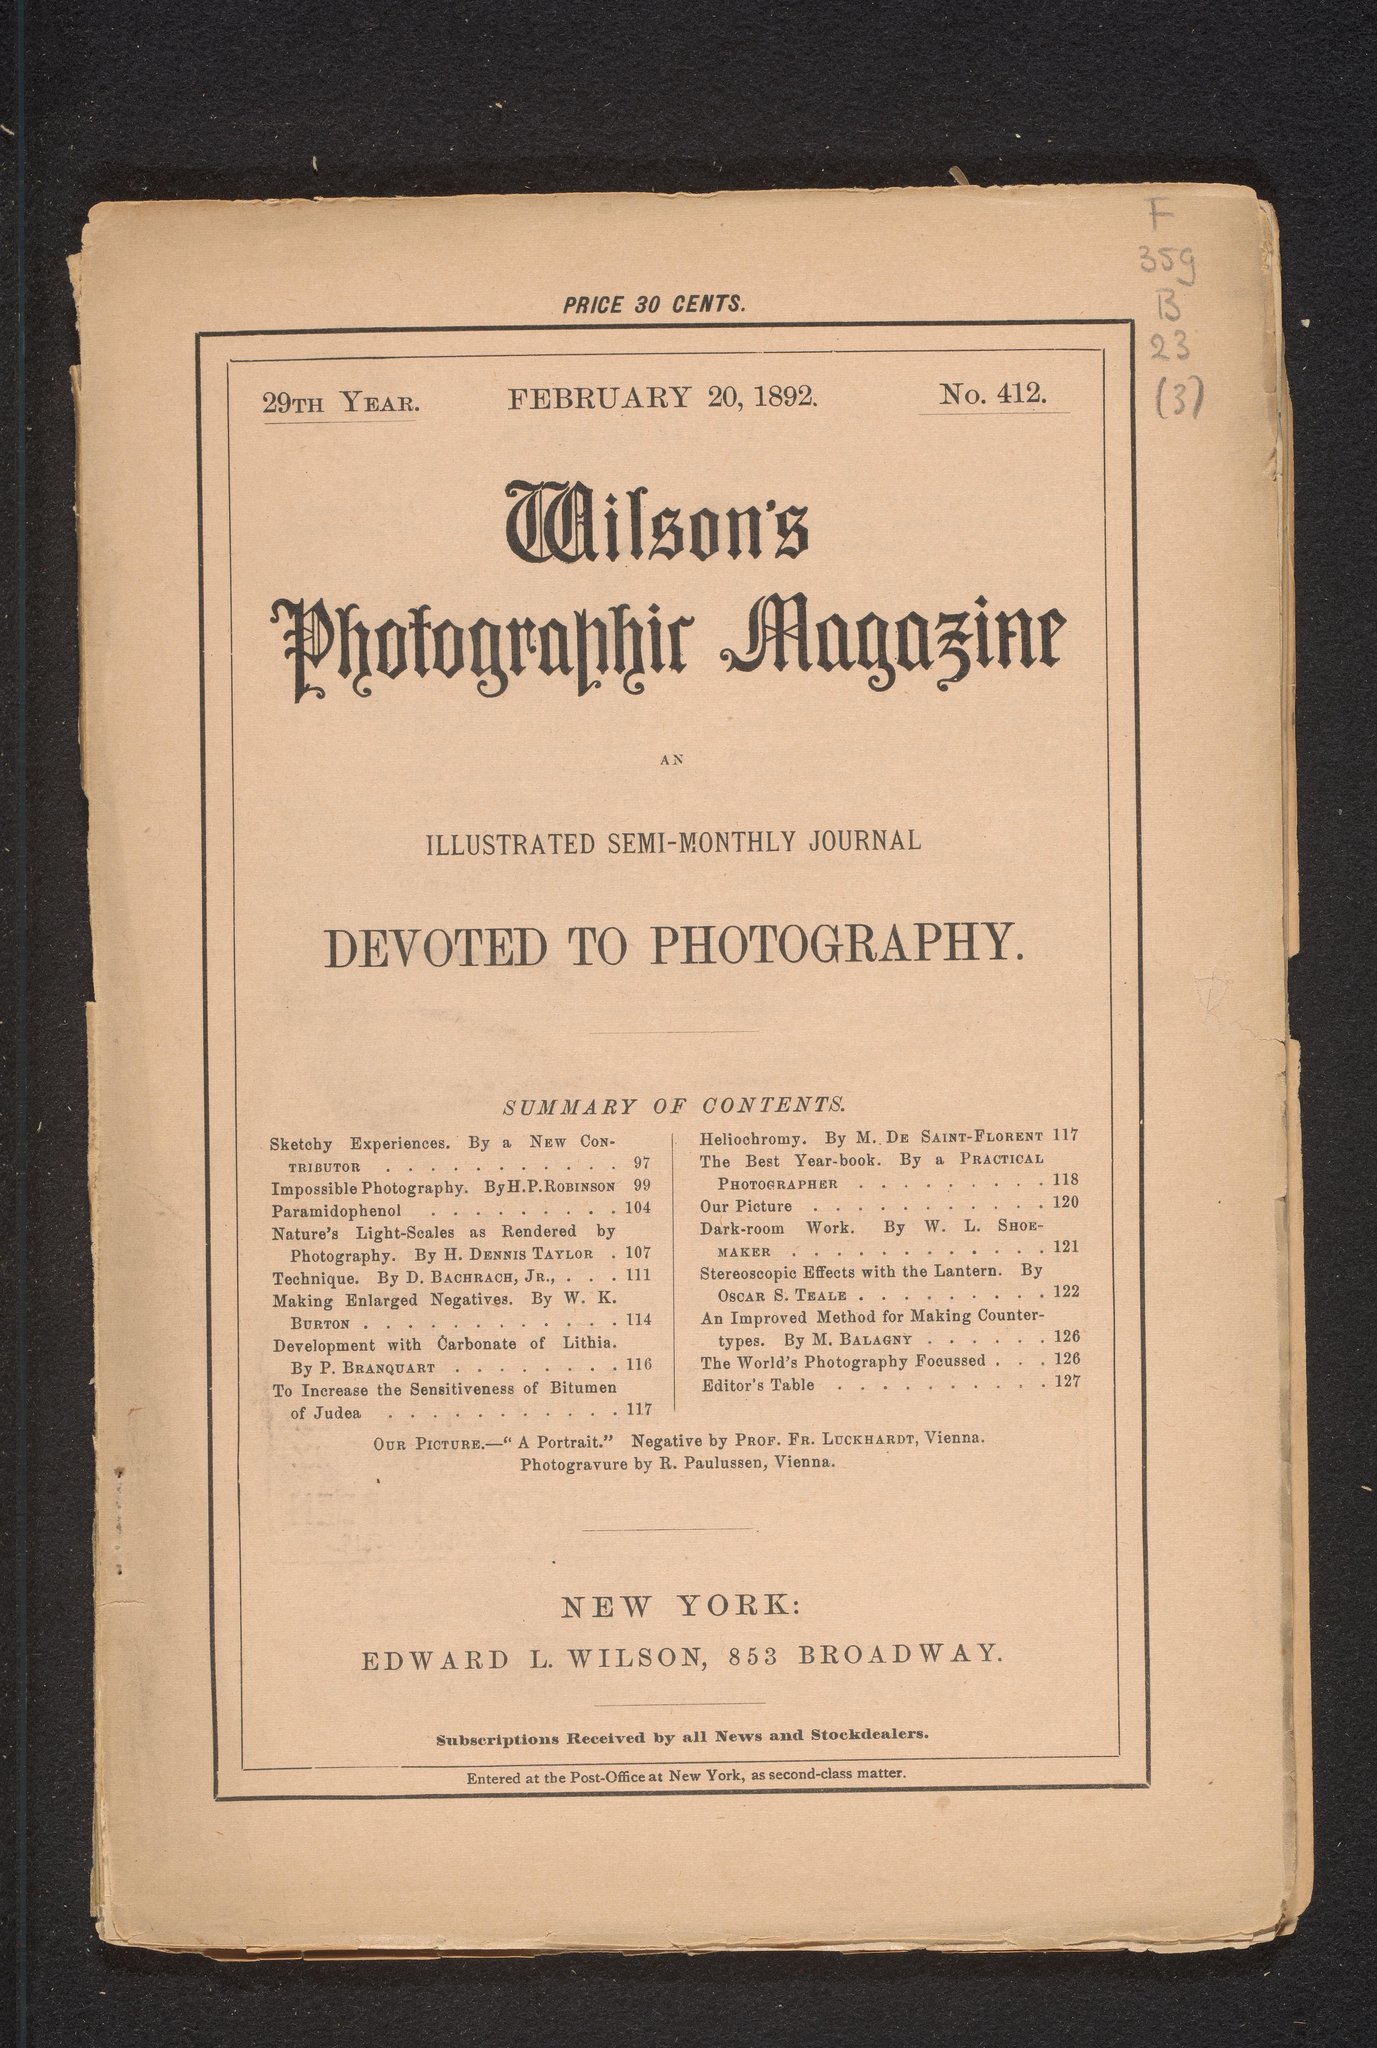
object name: magazine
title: Wilson's photographic magazine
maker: edward livingston wilson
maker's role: publisher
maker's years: 1838-1903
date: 1892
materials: paper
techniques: photoaquatint, printing, printing block, engraving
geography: new york city